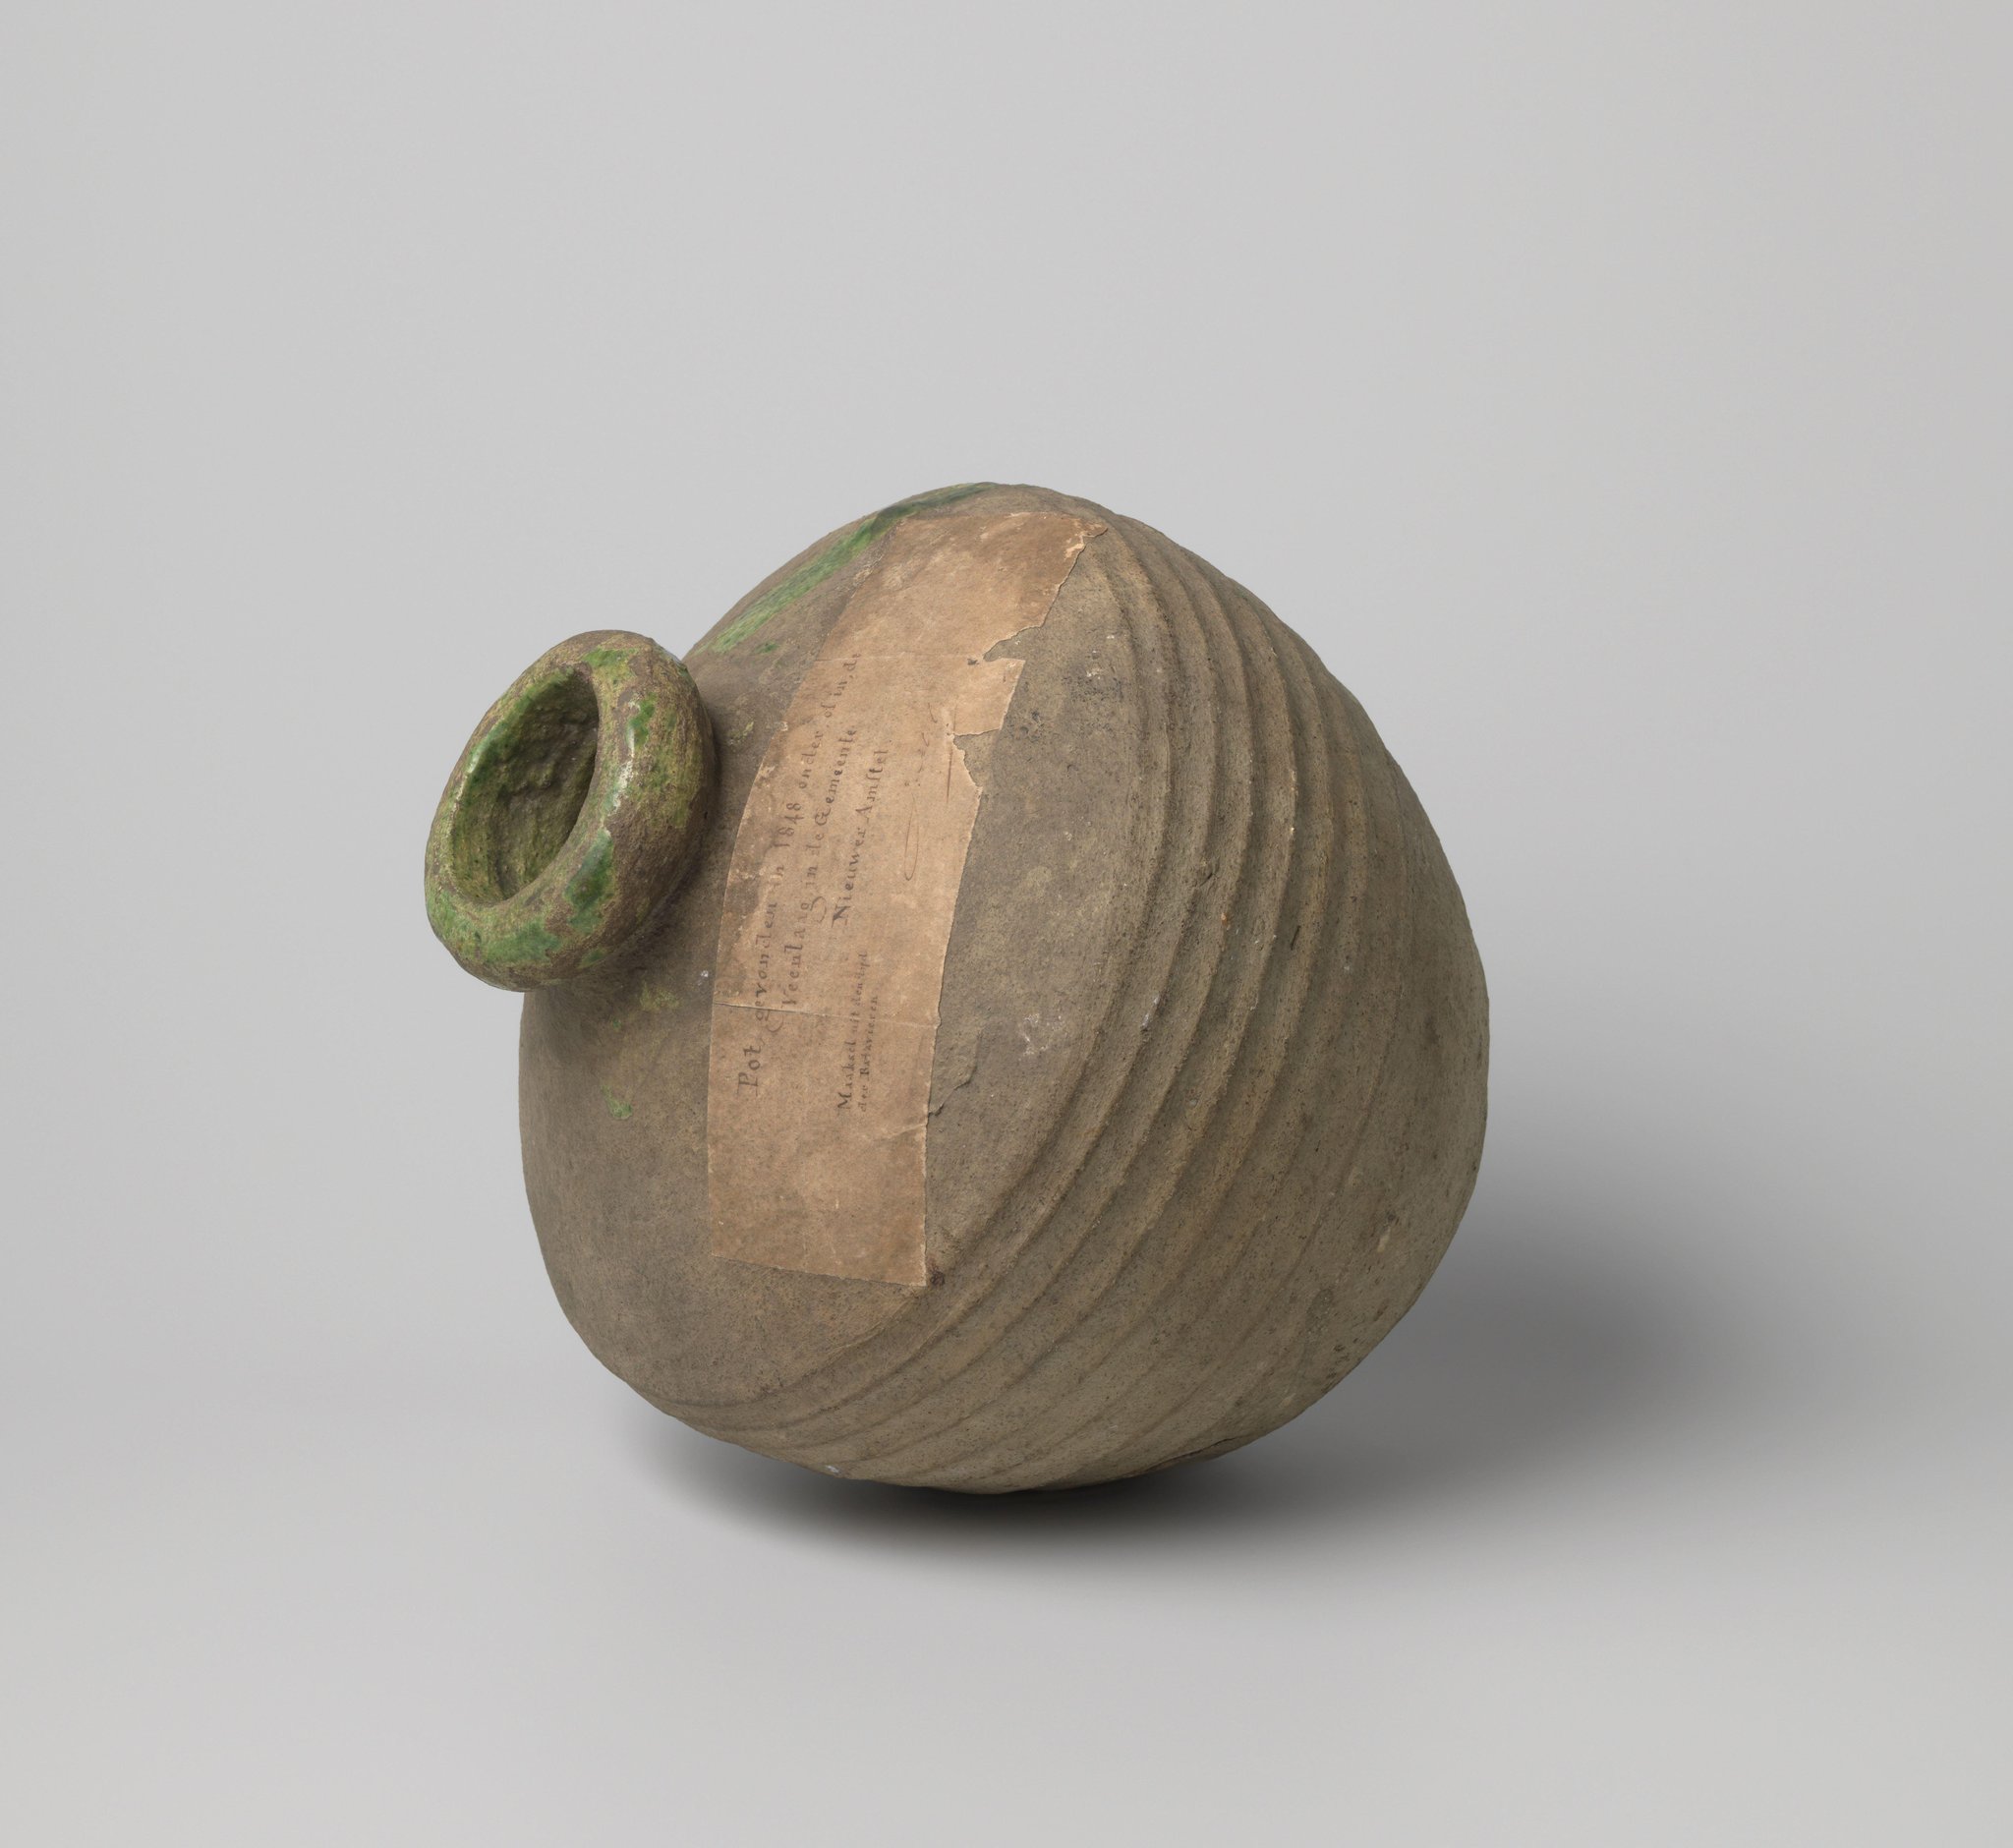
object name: urn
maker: Anonymous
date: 1400-1950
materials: earthenware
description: Urn, aan onderzijde puntig toelopend. Breed geschouderd waaronder tapstoelopend geribde wand. Dikke rand om de mond van de pot. Resten van groene glazuur.